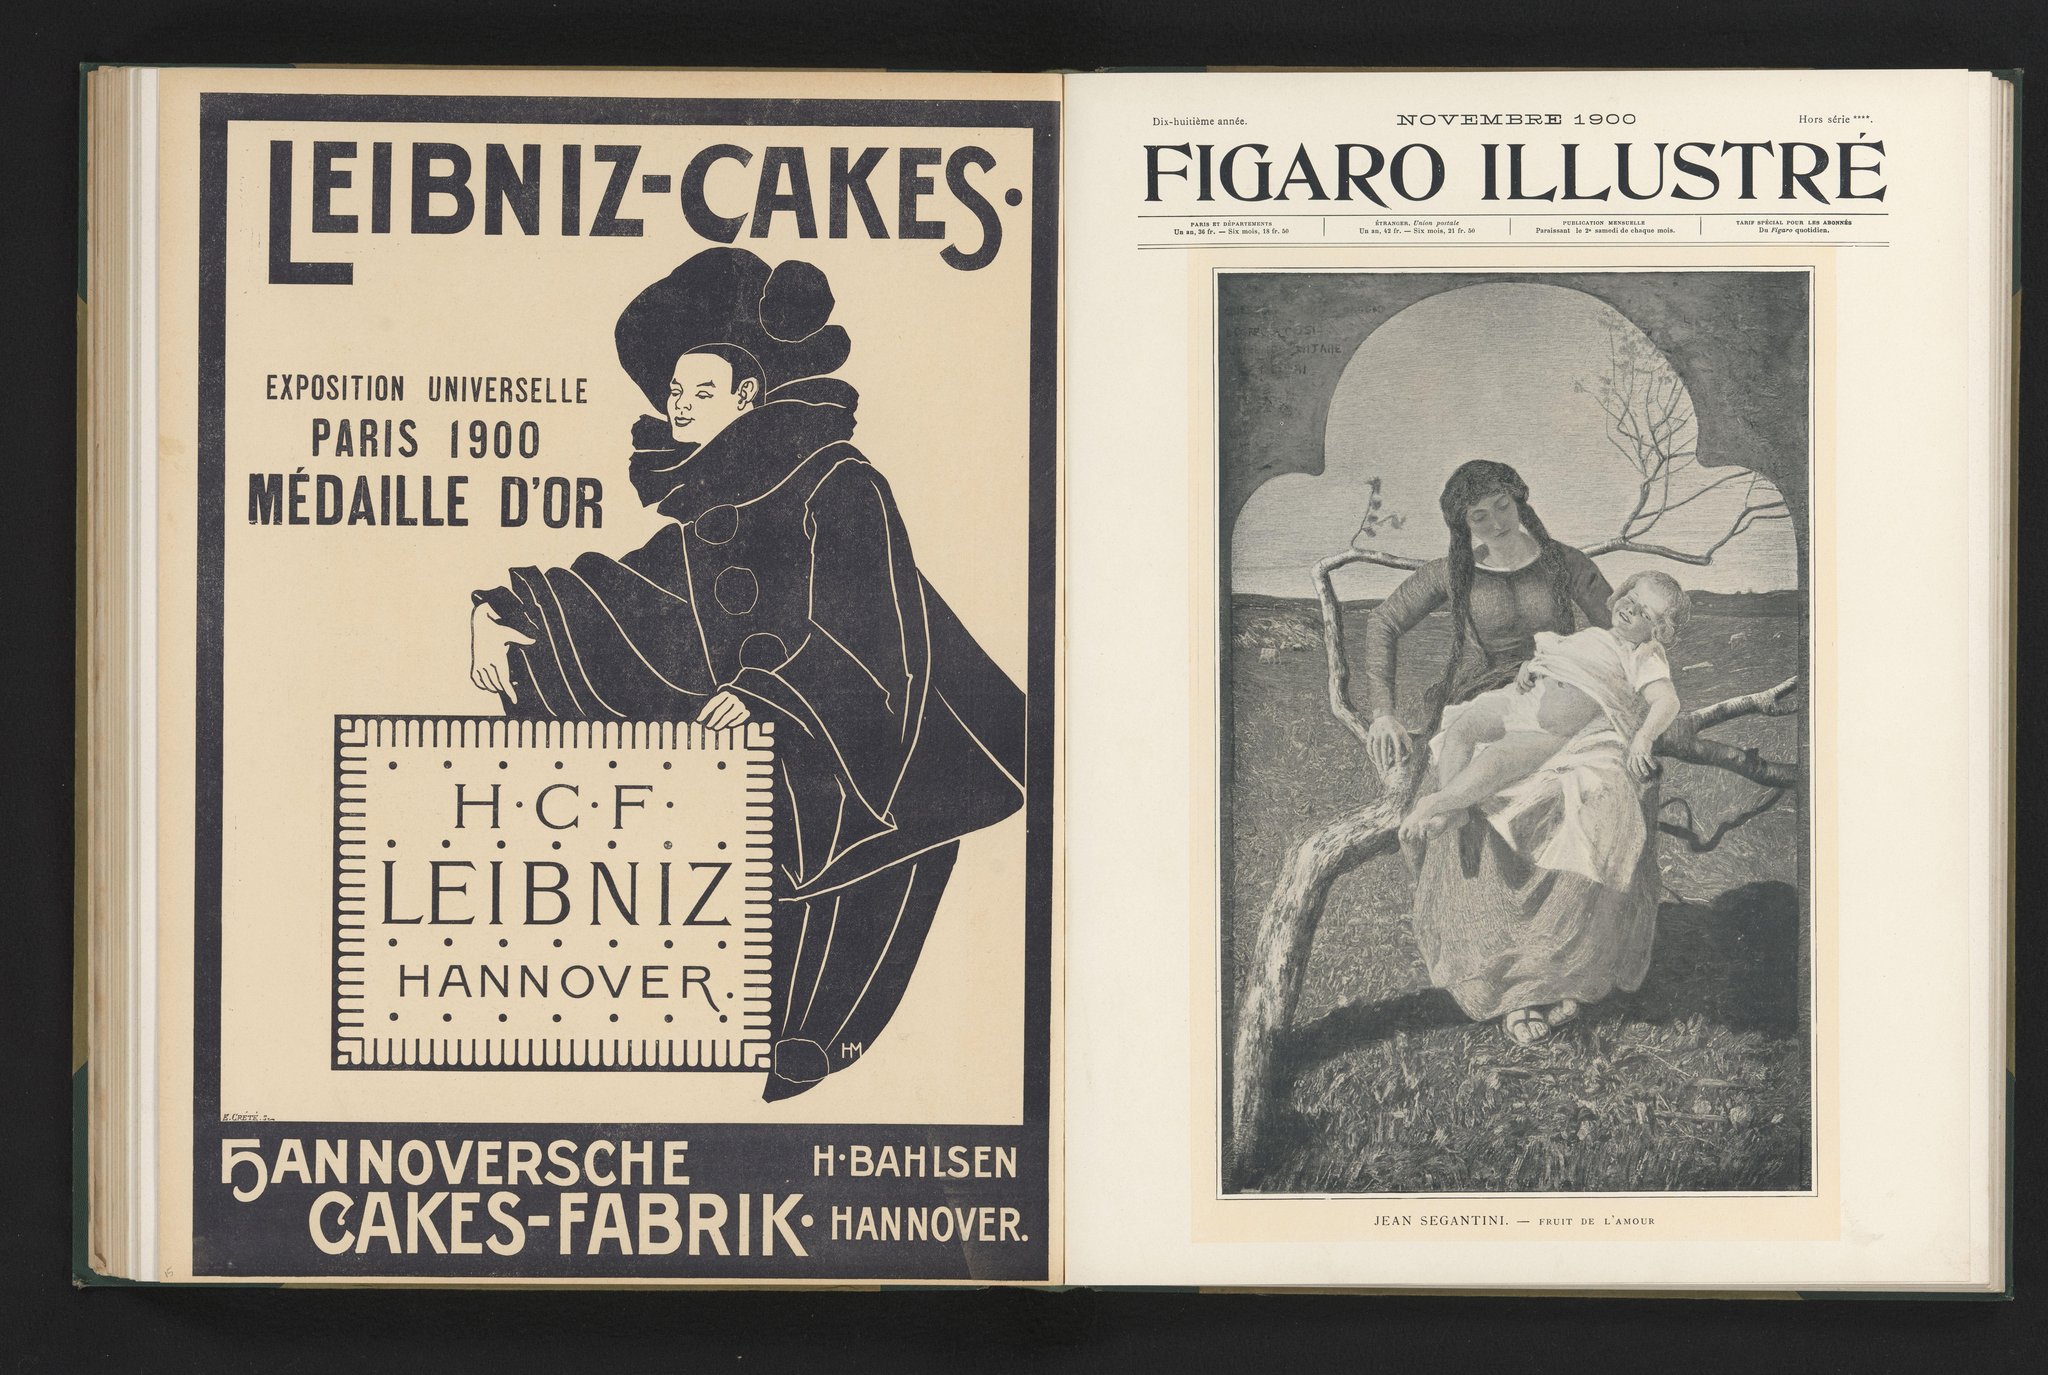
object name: page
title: Reproductie van een schilderij van een moeder met kind gezeten op een boomstam door Giovanni Segantini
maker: Anonymous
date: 1885-1901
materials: paper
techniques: autotype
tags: mother and baby or young child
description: Prent op titelpagina van Figaro-Illustré (Novembre 1900).